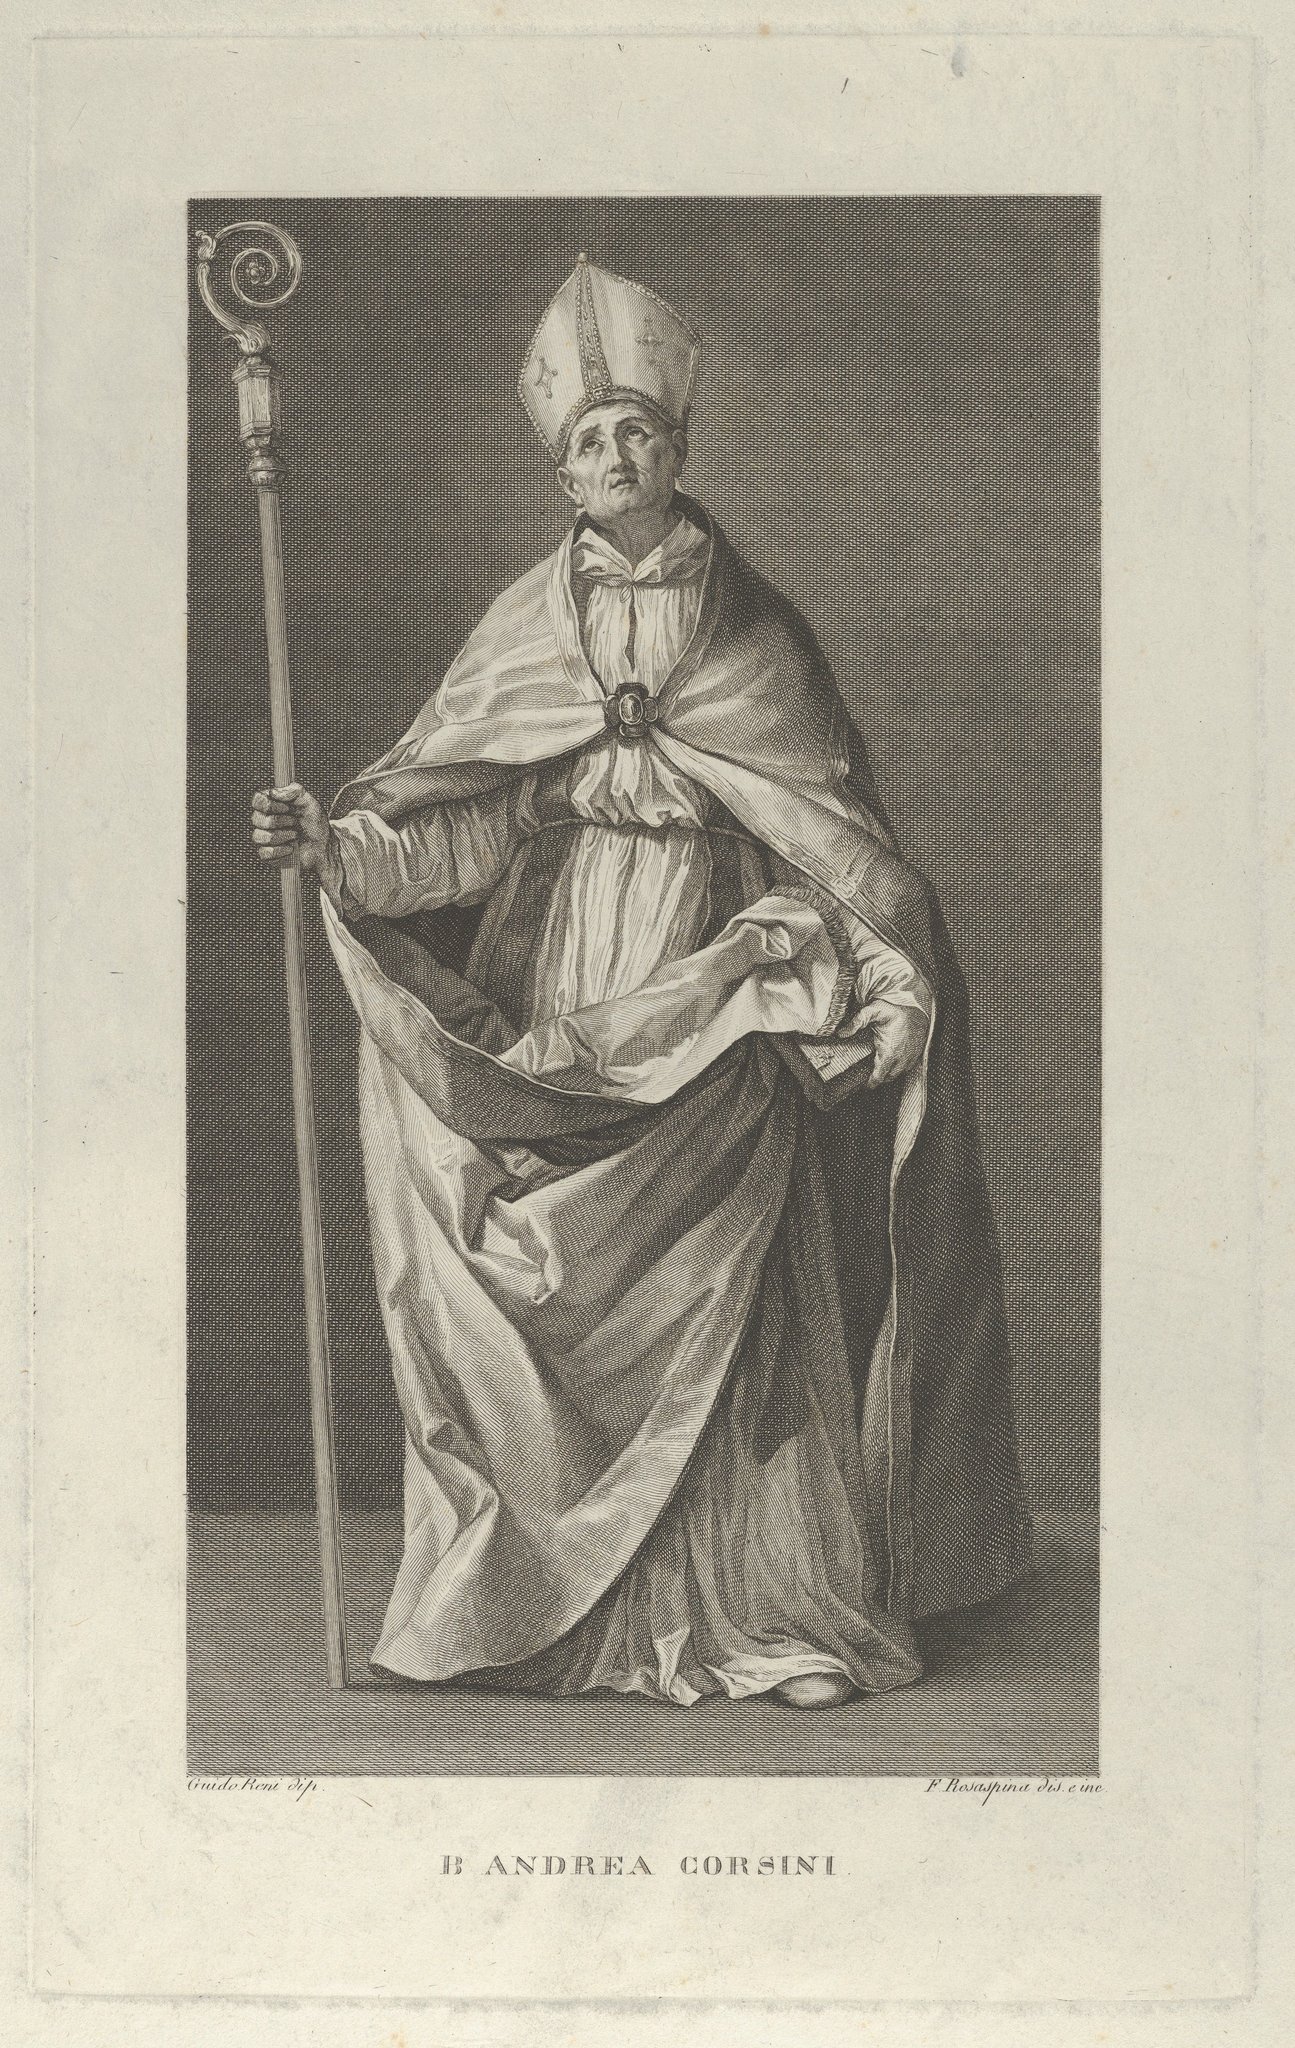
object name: print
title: Saint Andrea Corsini dressed as Bishop of Fiesole, holding a crosier and looking up, after Reni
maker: francesco rosaspina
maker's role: artist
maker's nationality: italian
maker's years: 1762-1841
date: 1780-1841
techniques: etching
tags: saints